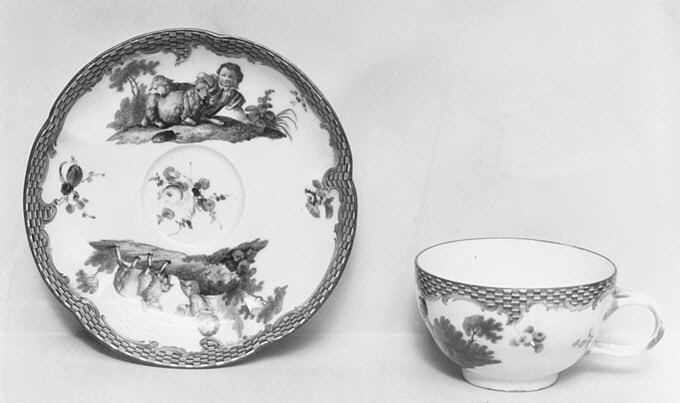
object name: cup and saucer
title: Cup and saucer (part of a set)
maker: meissen manufactory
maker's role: manufactory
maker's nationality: german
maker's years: 1710-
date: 1765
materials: hard paste porcelain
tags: children,lambs,flowers